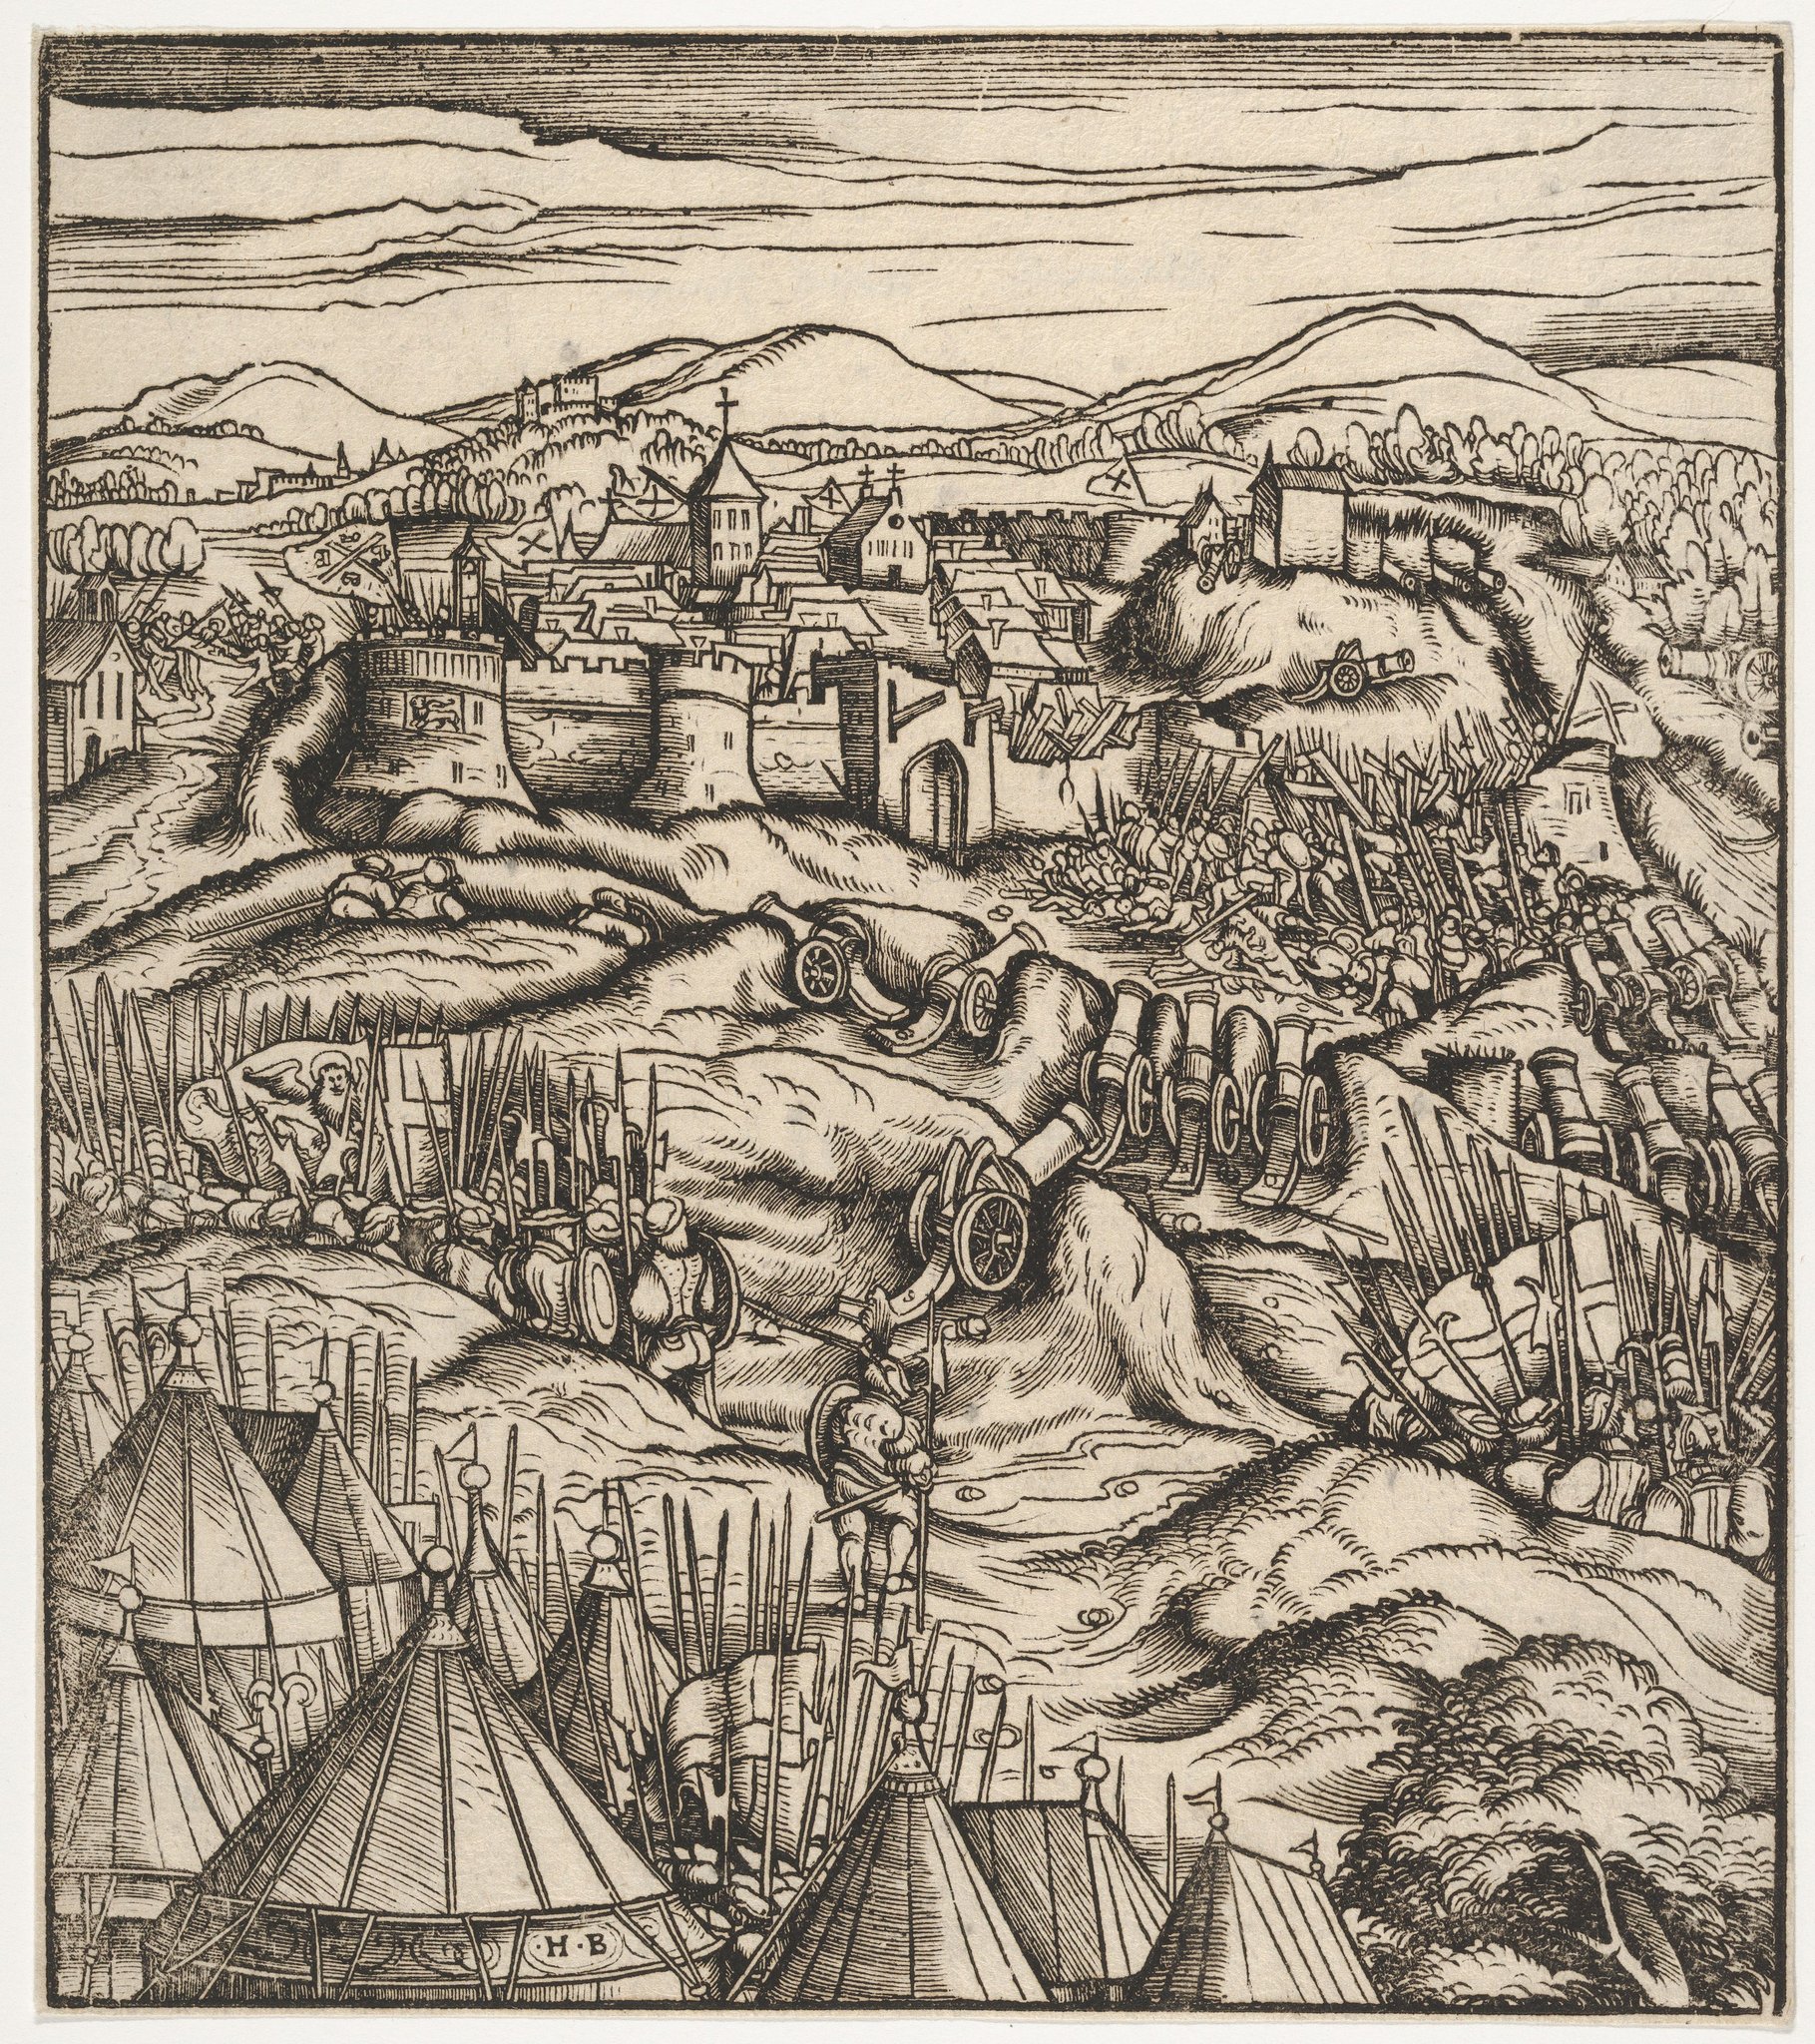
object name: print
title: The Conquest of Gradisca, from "Der Weisskunig"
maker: hans burgkmair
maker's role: artist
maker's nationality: german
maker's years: 1473-1531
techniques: woodcut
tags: buildings,churches,soldiers,cannons